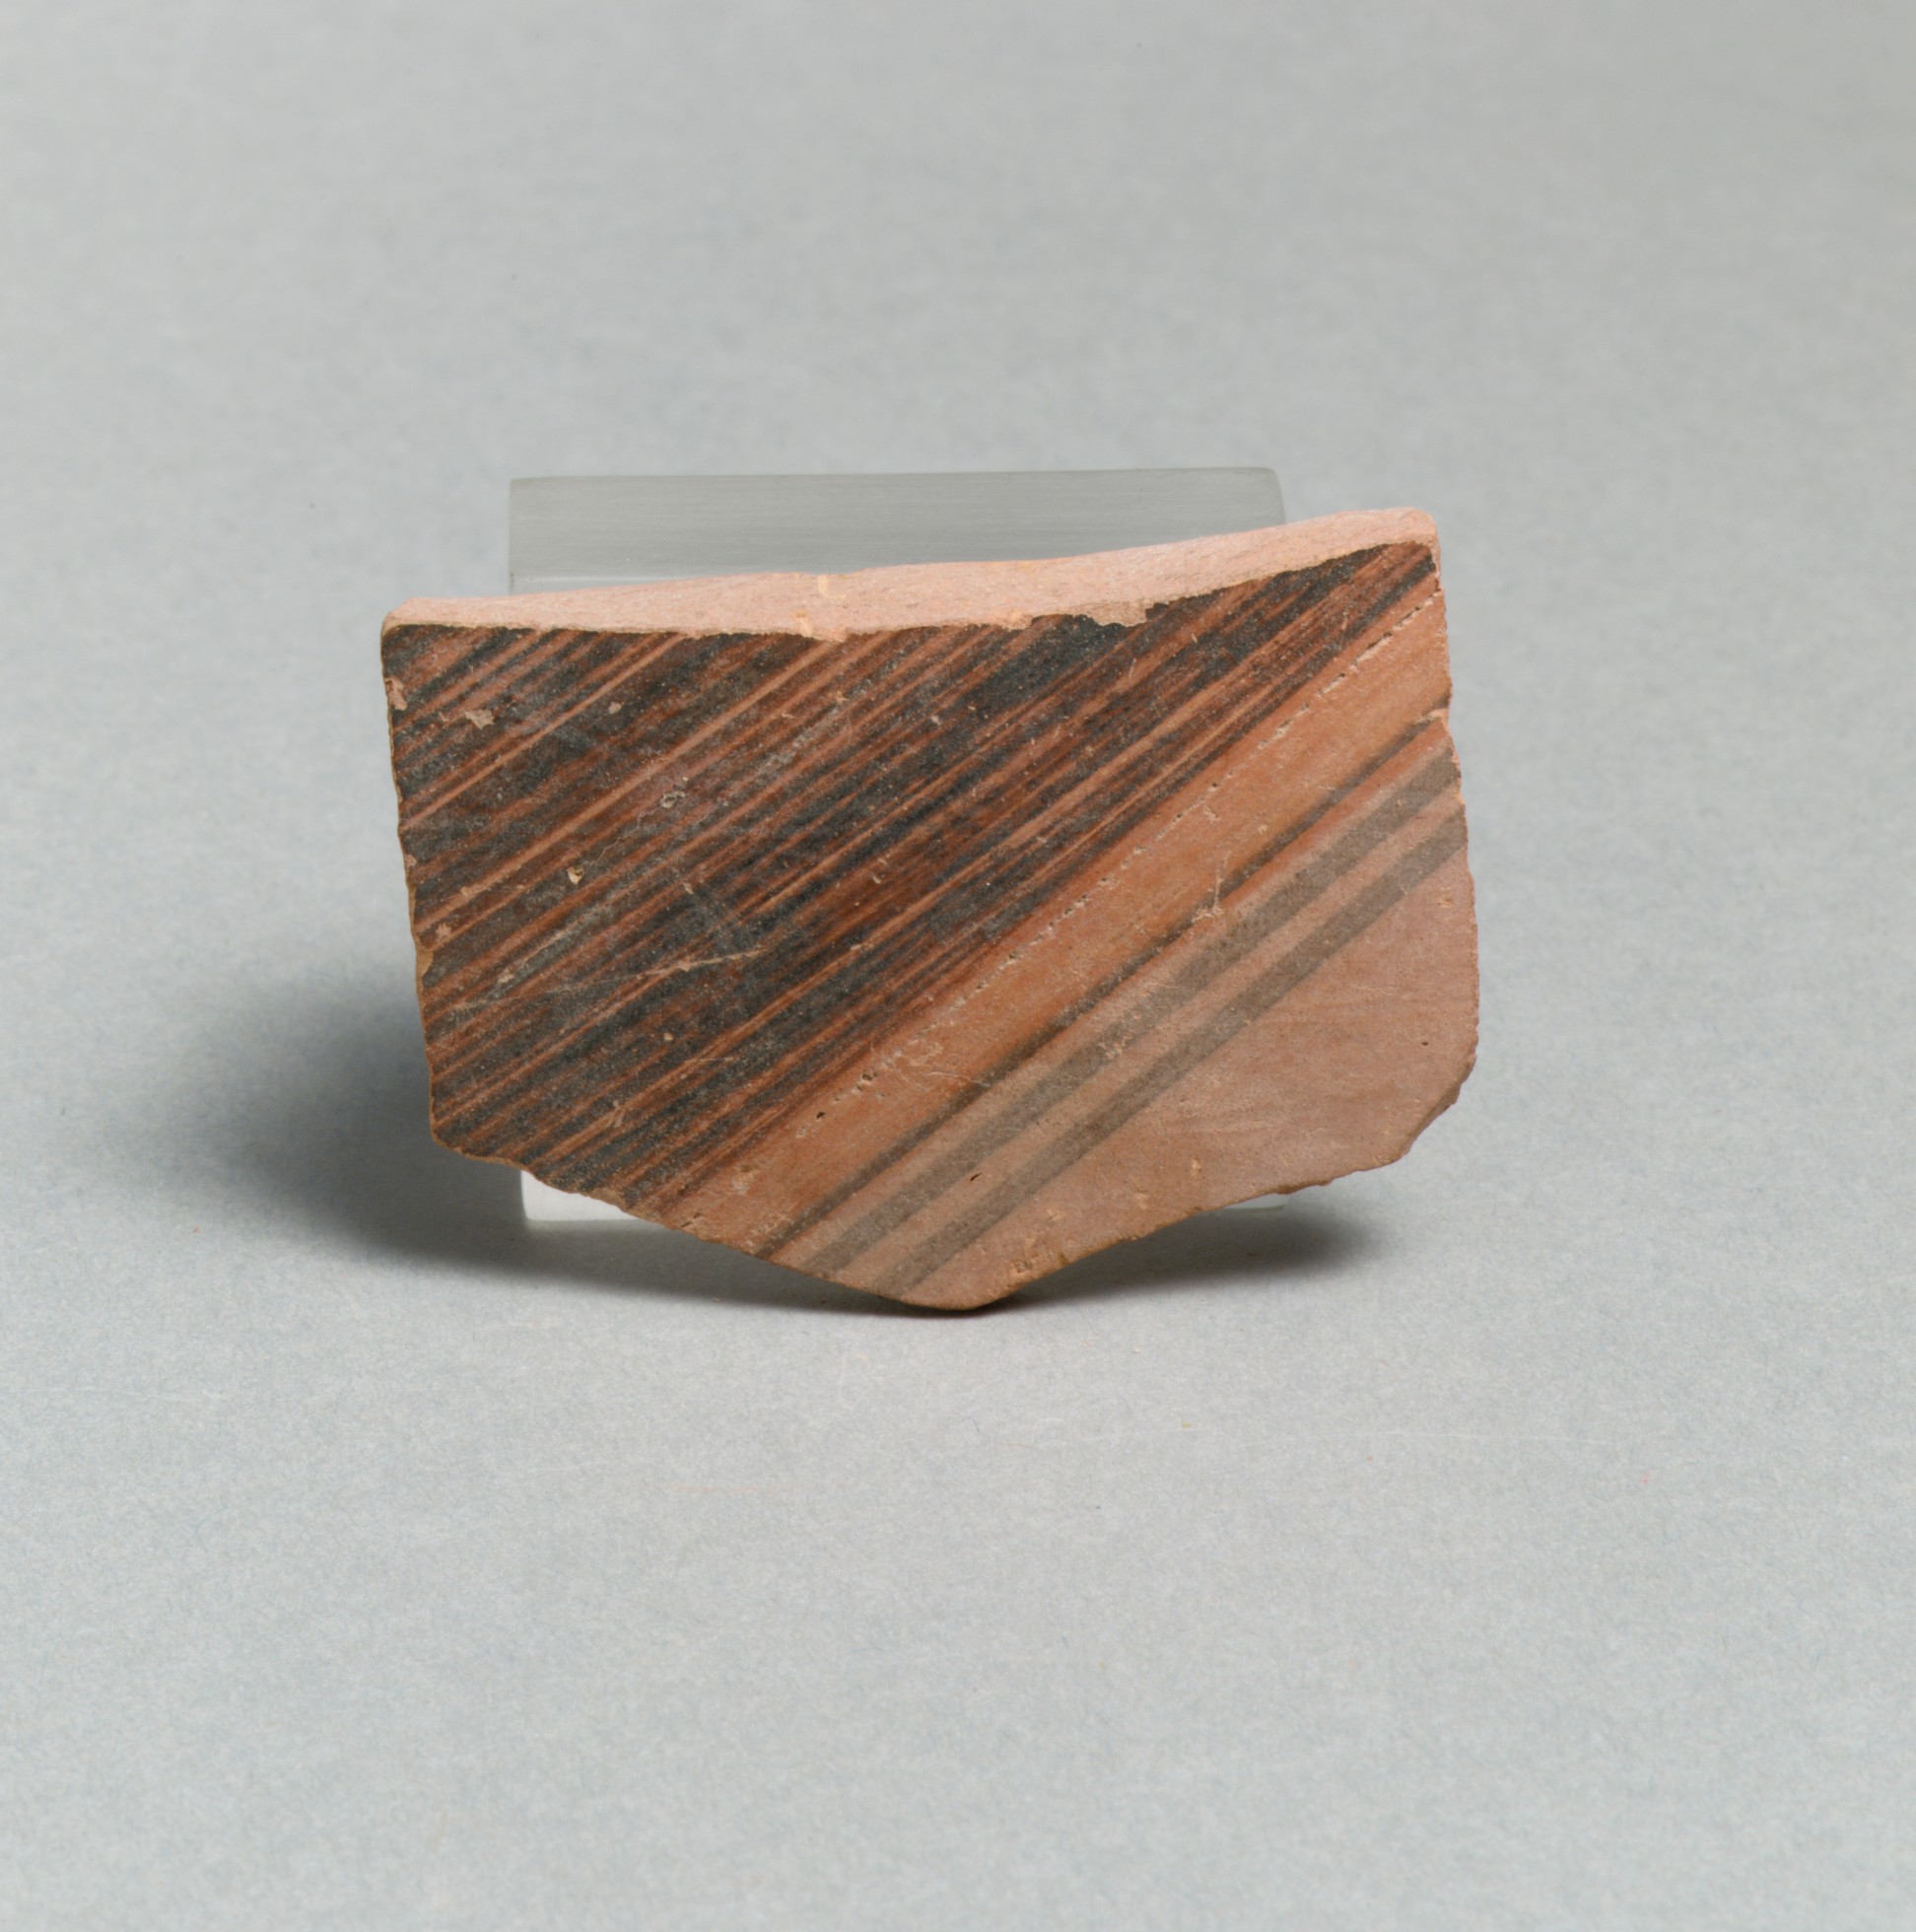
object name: vase fragment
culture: greek or lydian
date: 900-30 BCE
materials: terracotta